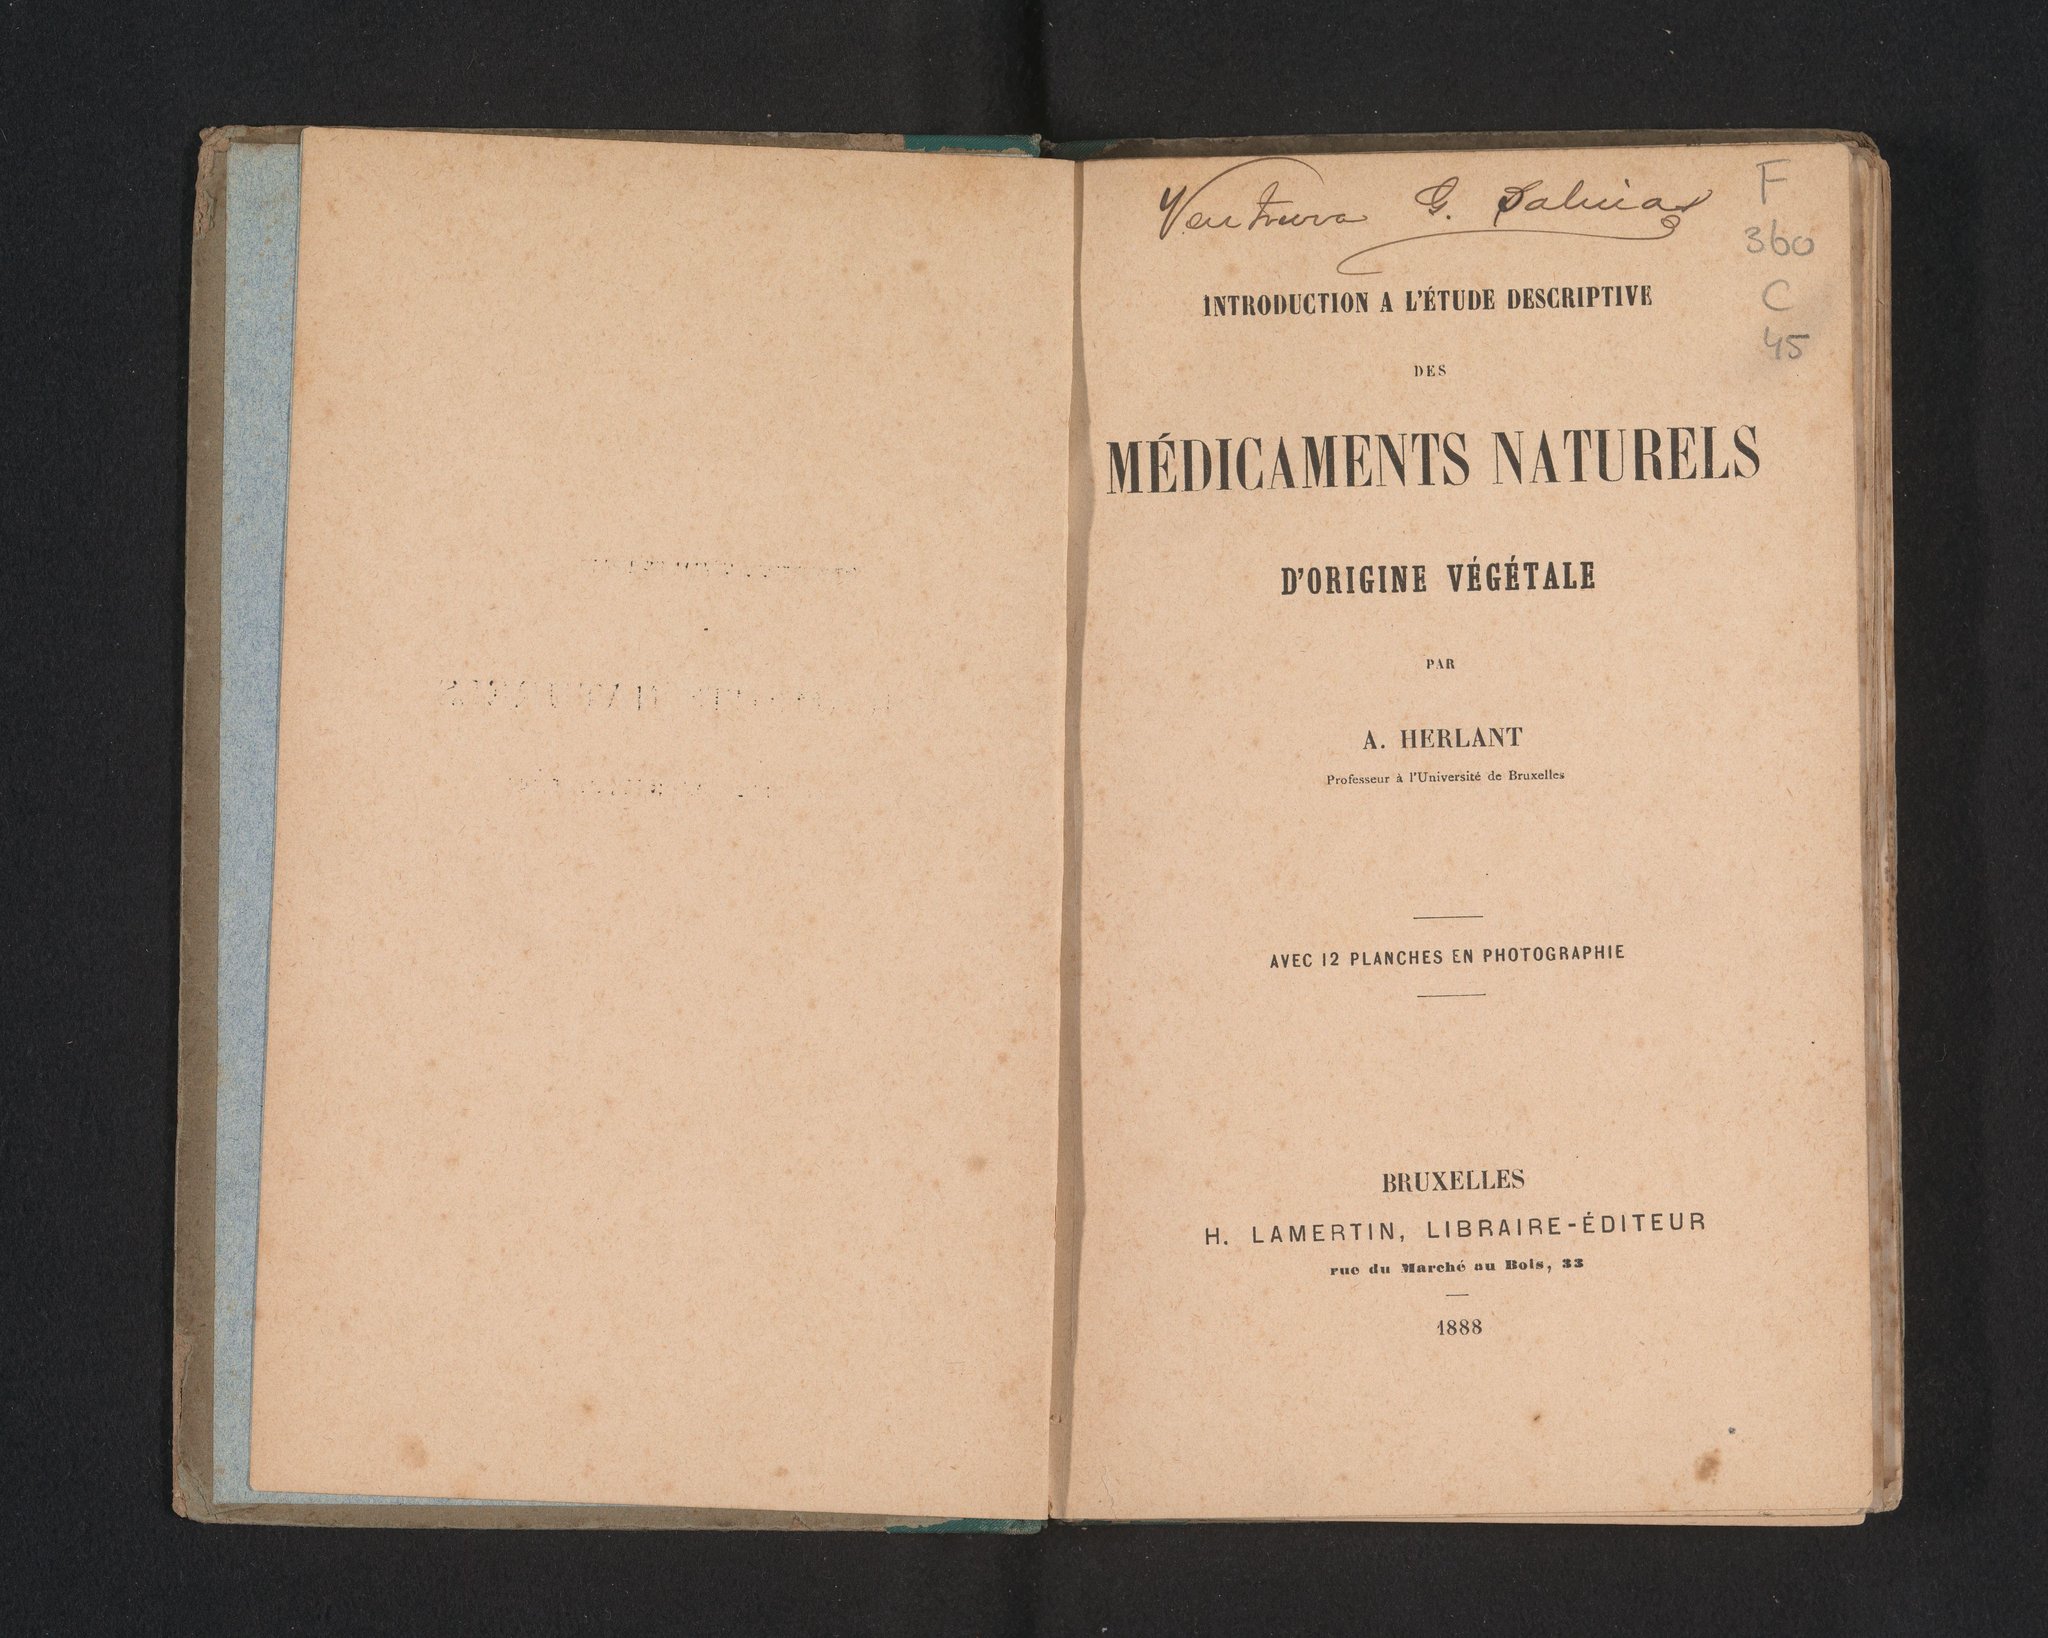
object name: book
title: Introduction à l'étude descriptive des médicaments naturels d'origine végétale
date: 1888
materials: paper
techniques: albumen print, printing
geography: brussels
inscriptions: annotation: ‘(...)’, annotation: ‘June/ 2000’, annotation: ‘(...)’